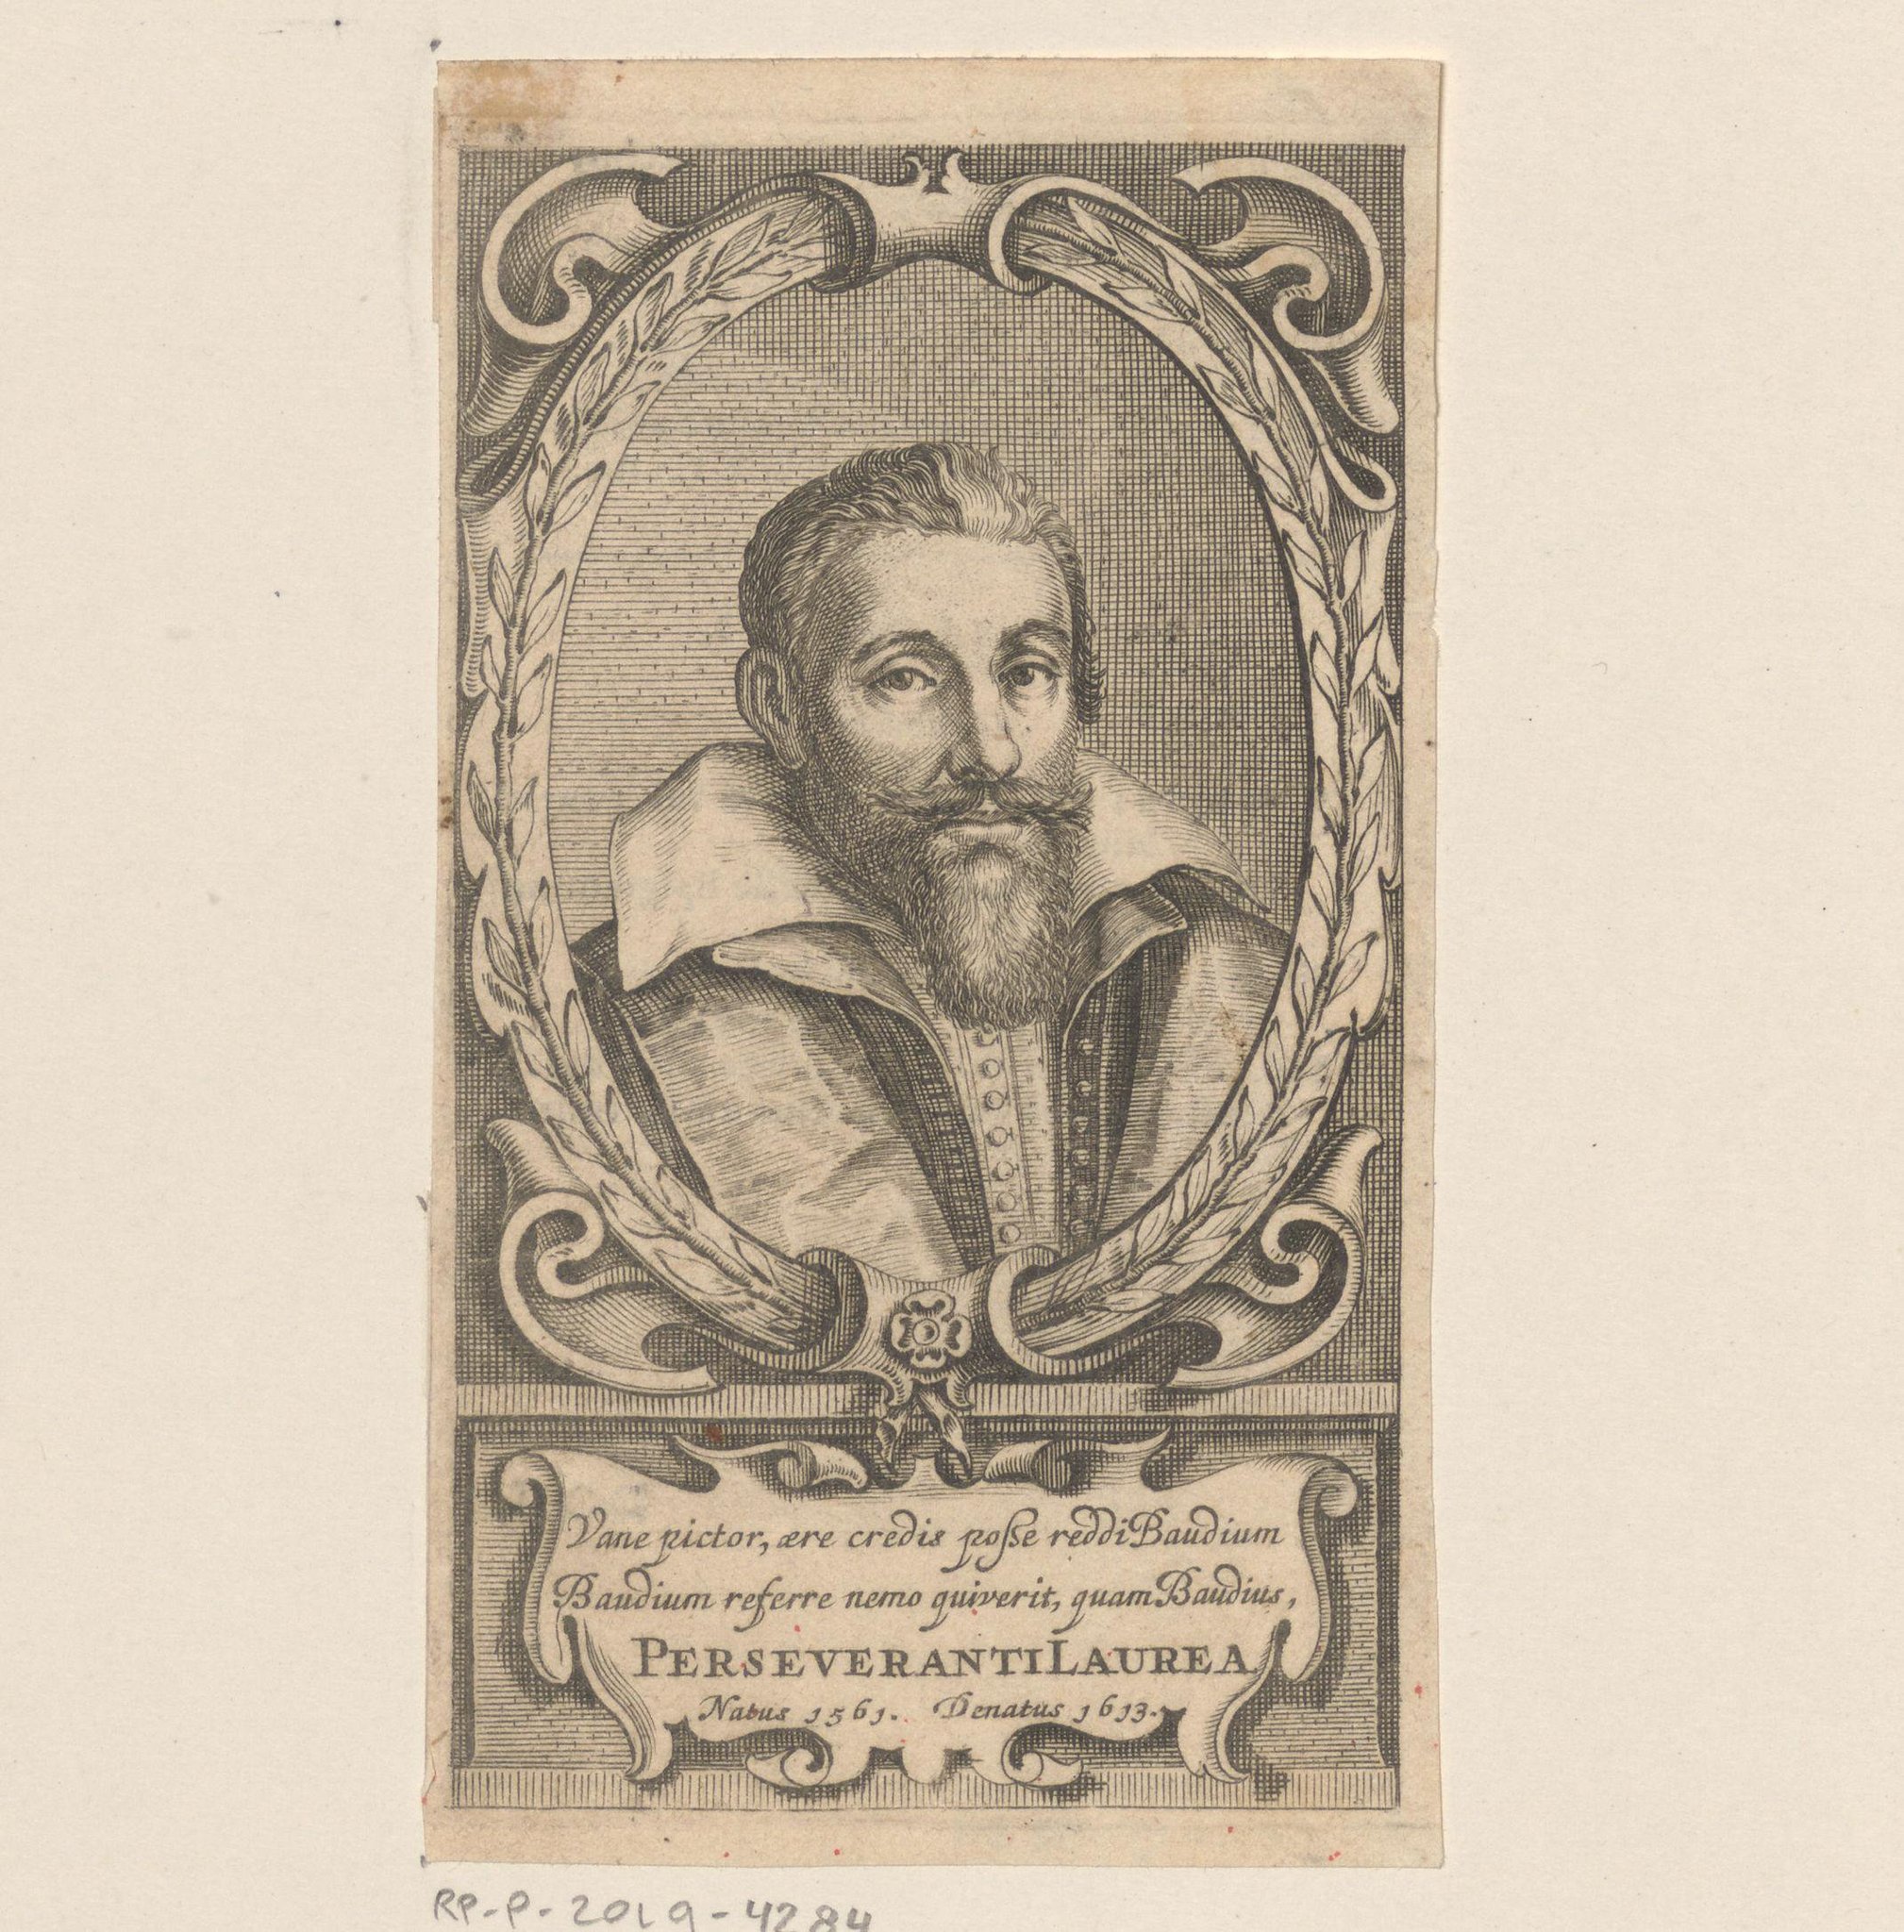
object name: print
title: Portret van Dominicus Baudius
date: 1640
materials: paper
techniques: engraving, etching, letterpress printing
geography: amsterdam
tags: lille, leiden, dominicus baudius, historical persons, writer, poet, author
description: Prent uit: Baudius, Dominicus. Poemata. Amsterdam: Johannes Janssonius, 1640.